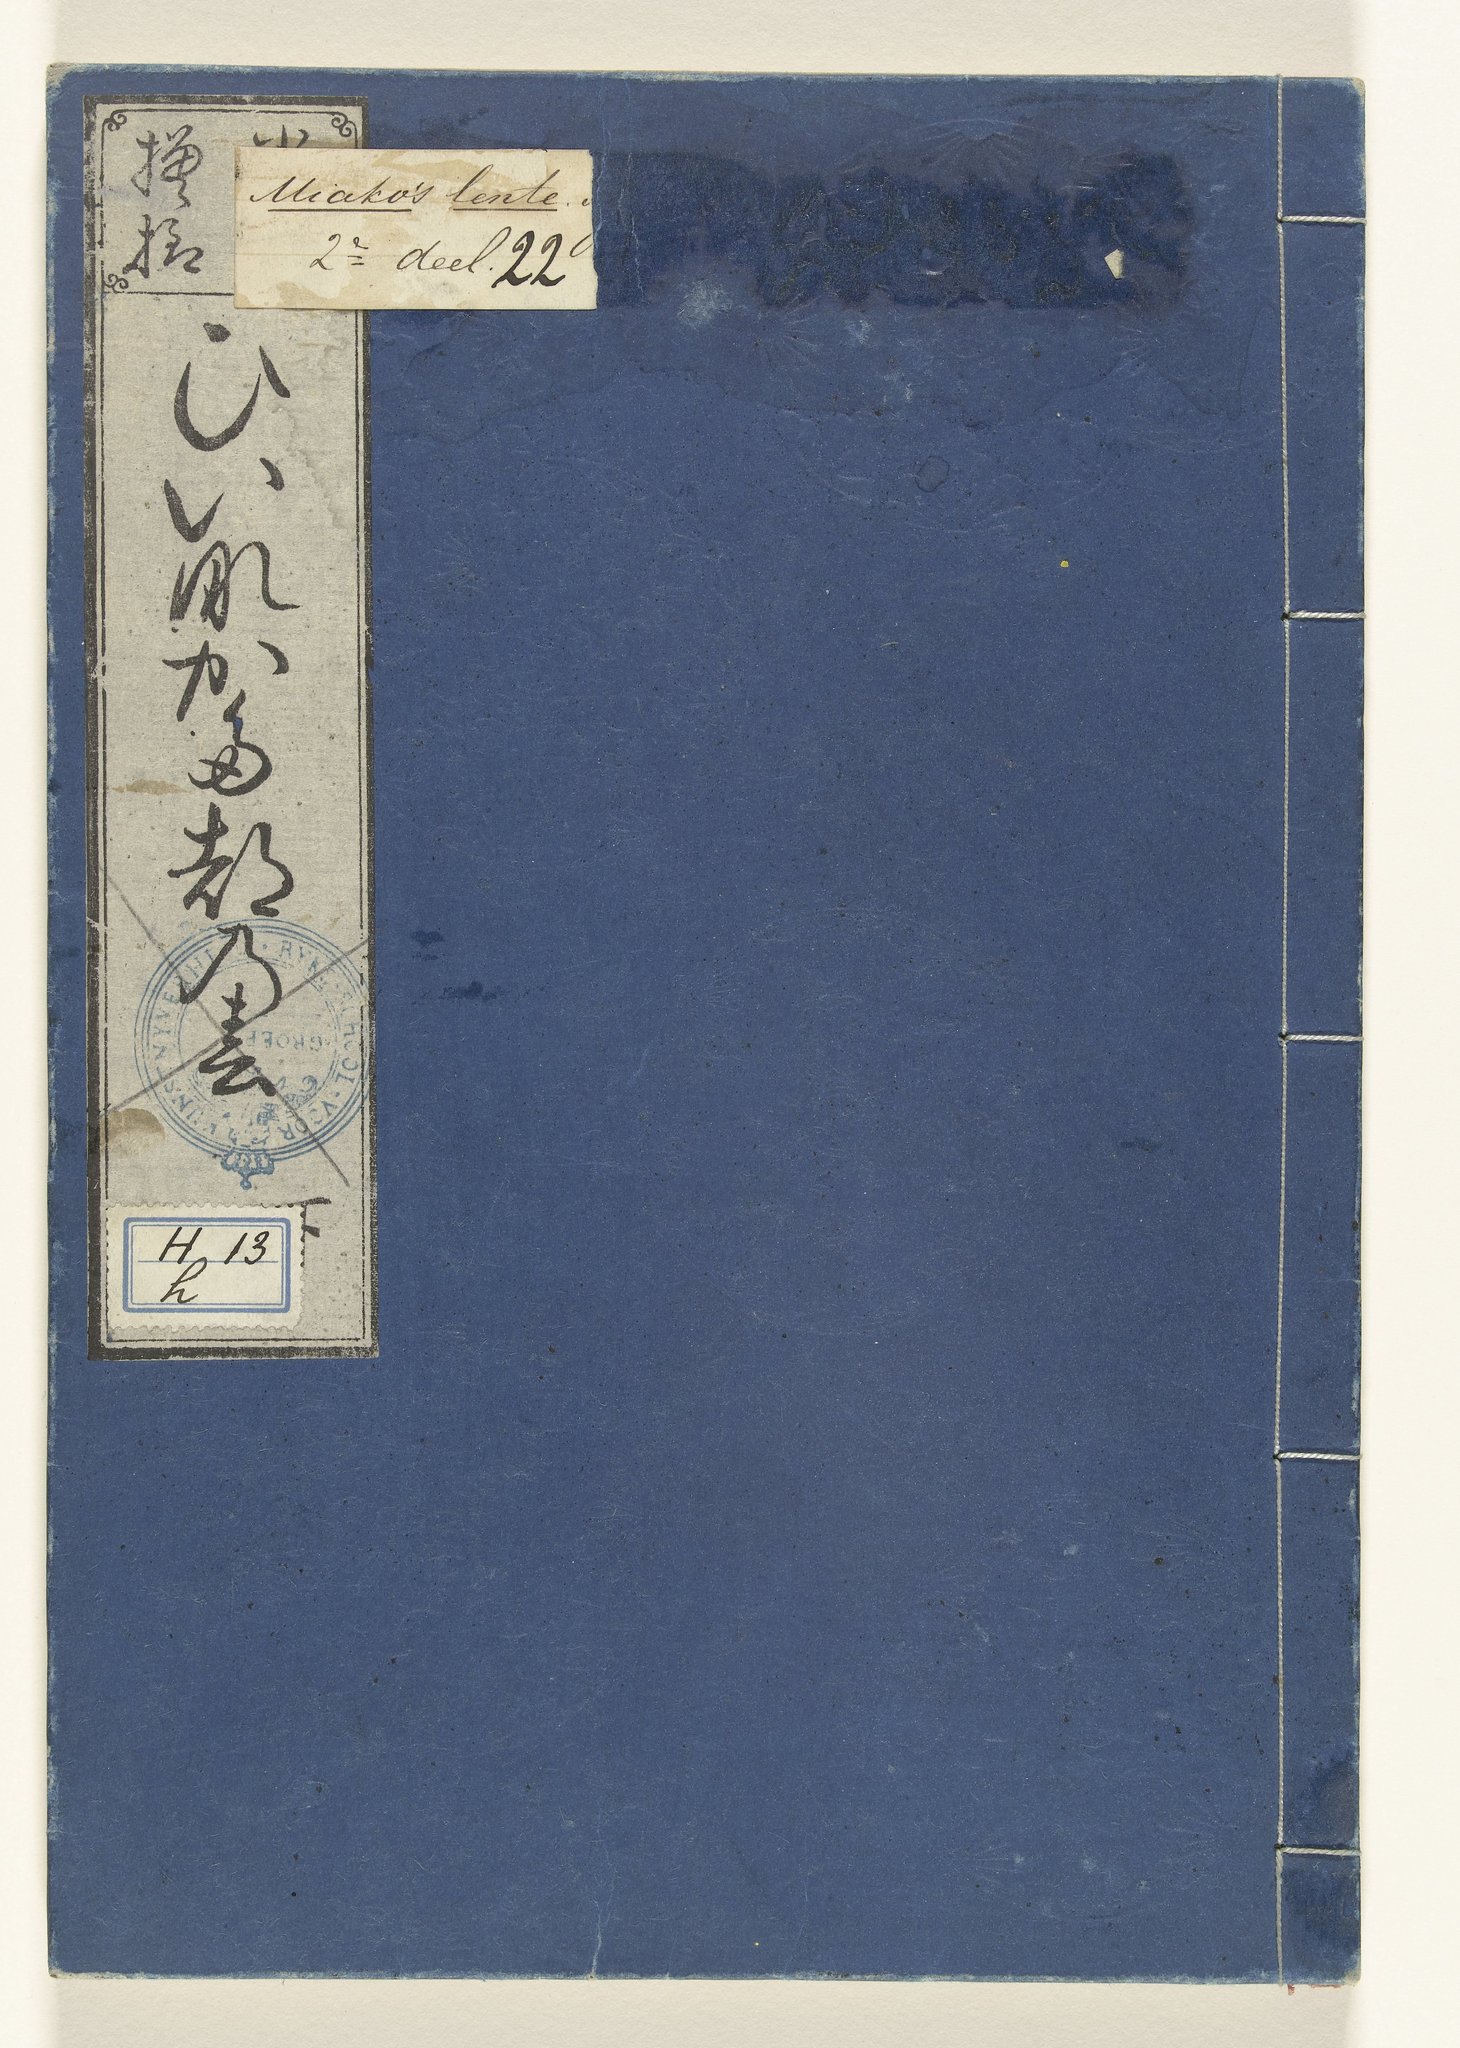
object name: book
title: Hinagata Miyako no haru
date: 1885-1890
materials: paper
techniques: woodcut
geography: osaka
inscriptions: collector's mark: ‘Rijksschool voor kunstnijverheid’ Lugt 3937